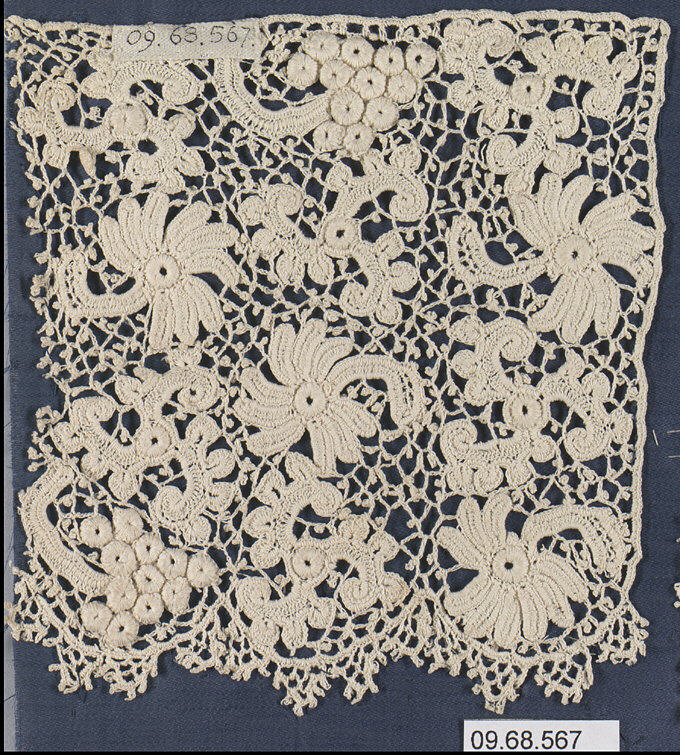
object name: specimen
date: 1801-1900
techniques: crochet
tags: flowers